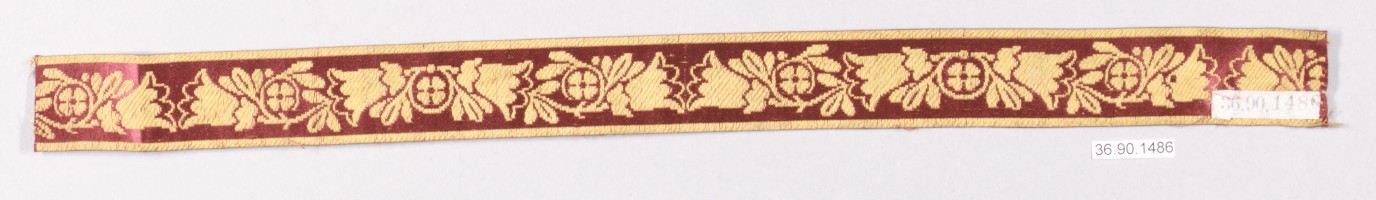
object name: ribbon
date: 1801-1900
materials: silk